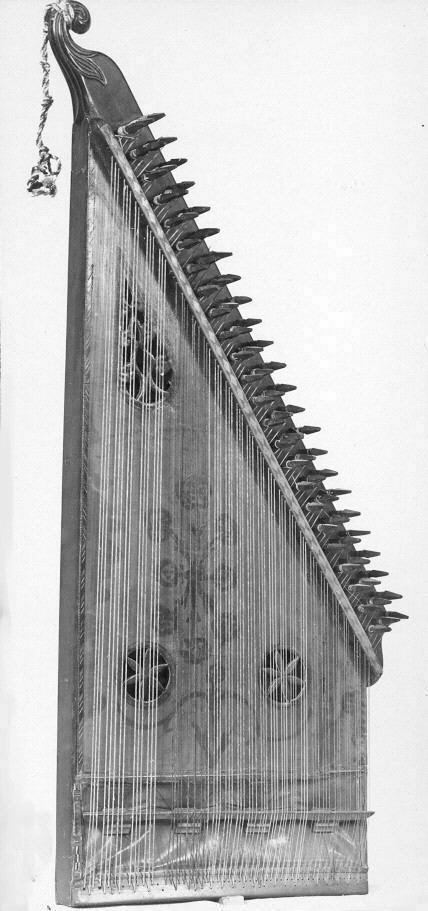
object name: qānūn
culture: turkish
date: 1867-1900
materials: metal, wood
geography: turkey